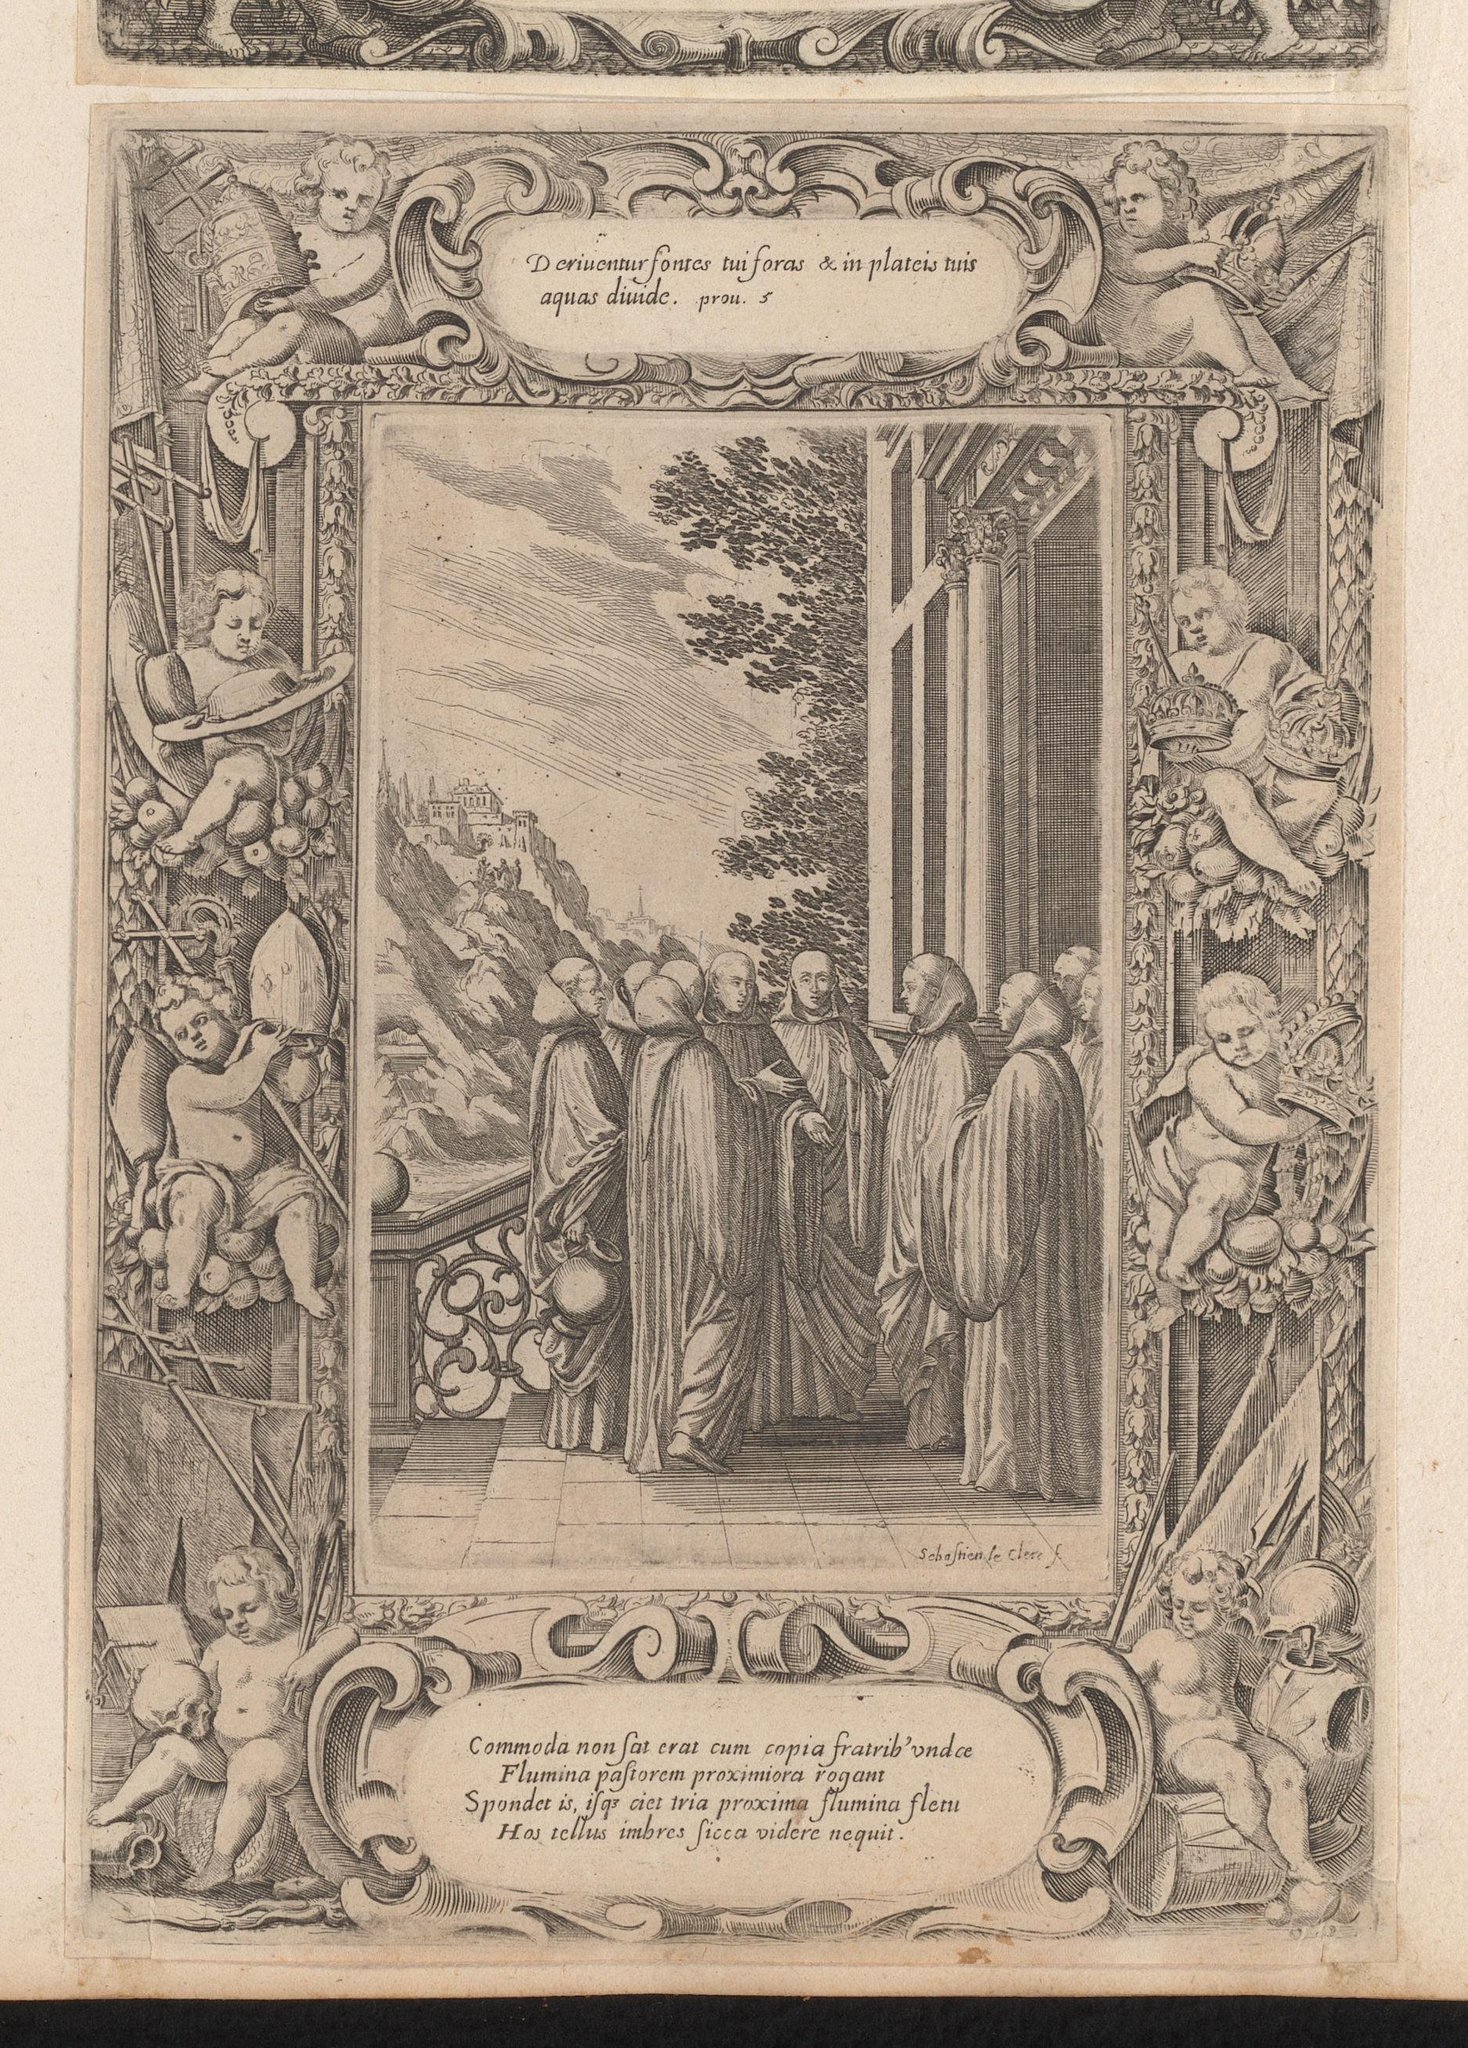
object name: album leaf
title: Scènes uit het leven van H. Benedictus van Nursia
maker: sébastien leclerc (i)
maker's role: print maker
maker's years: 1637-1714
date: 1658-1659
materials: paper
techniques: etching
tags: benedict of nurcia, abbot of monte cassino and founder of the benedictine order; possible attributes: aspergillum, book, cup (sometimes broken), raven with loaf, sieve (or tray)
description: Maakt deel uit van een serie bestaande uit 33 prenten met voorstellingen uit het leven van de Heilige Benedictus van Nursia in ornamentele cartouches, uitgegeven in 1658-1659. De prenten zijn gedrukt van drie afzonderlijke platen bestaande uit de voorstelling, de cartouche en de tekst.